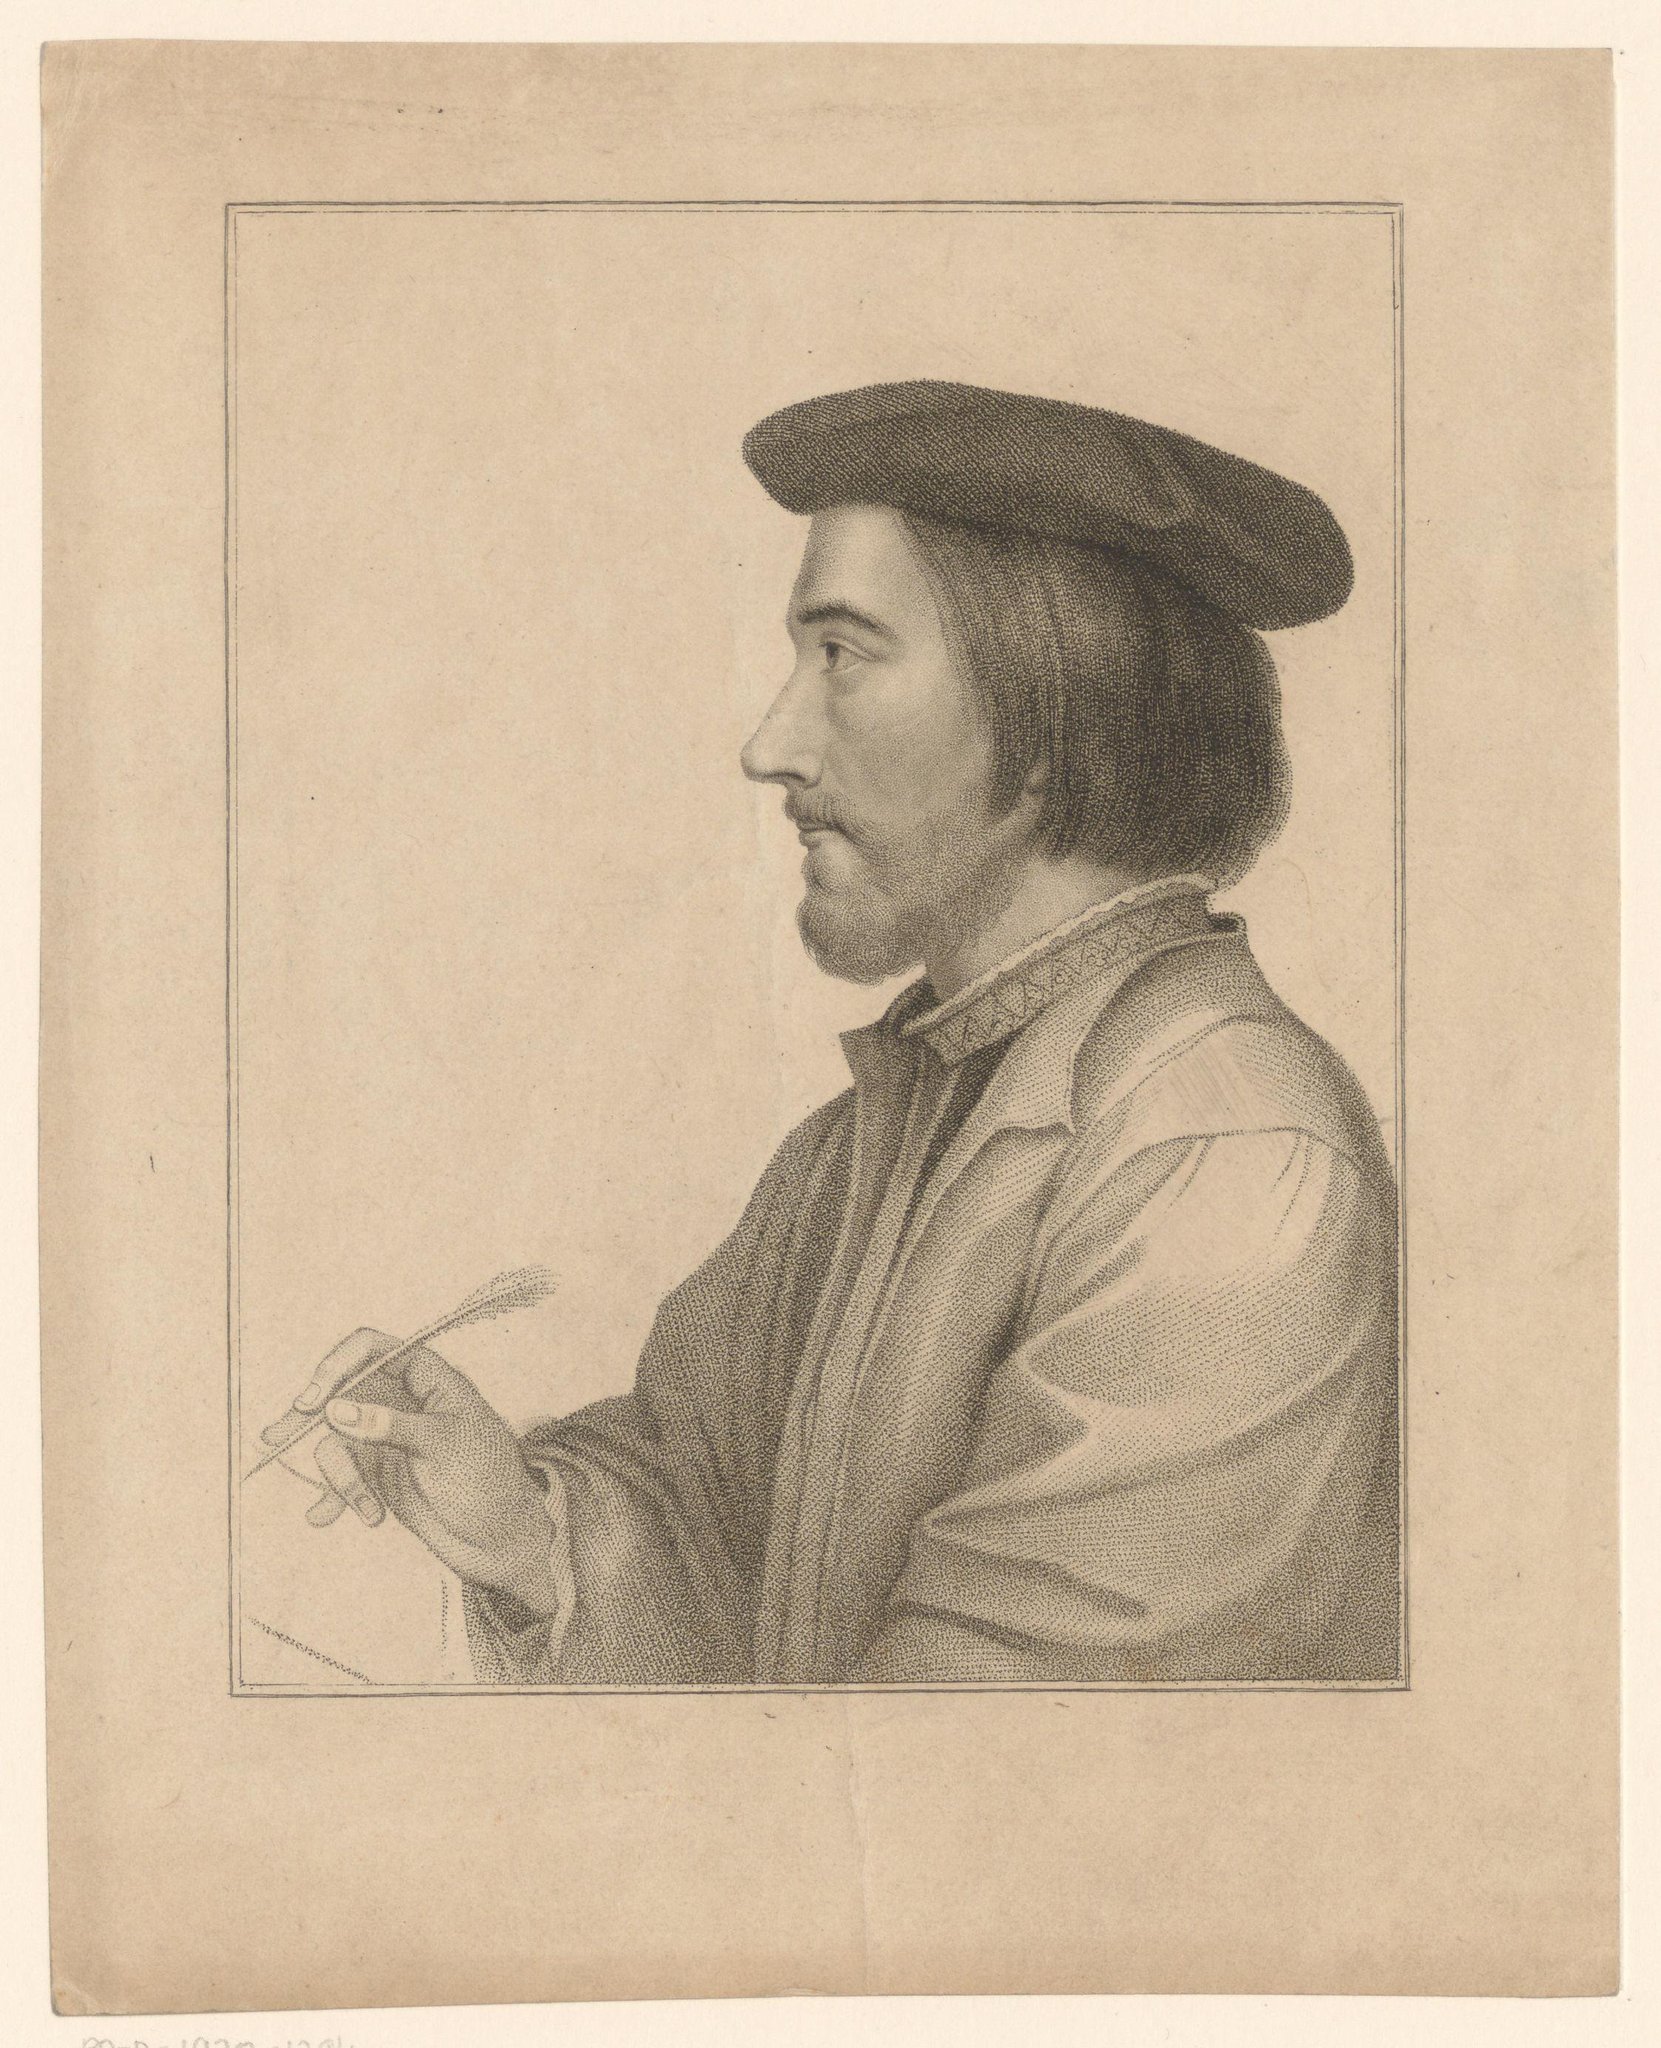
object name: print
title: Portret van Nicolas Bourbon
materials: paper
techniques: stippling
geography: london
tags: paris, historical persons, writer, poet, author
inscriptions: collector's mark: Lugt 2228